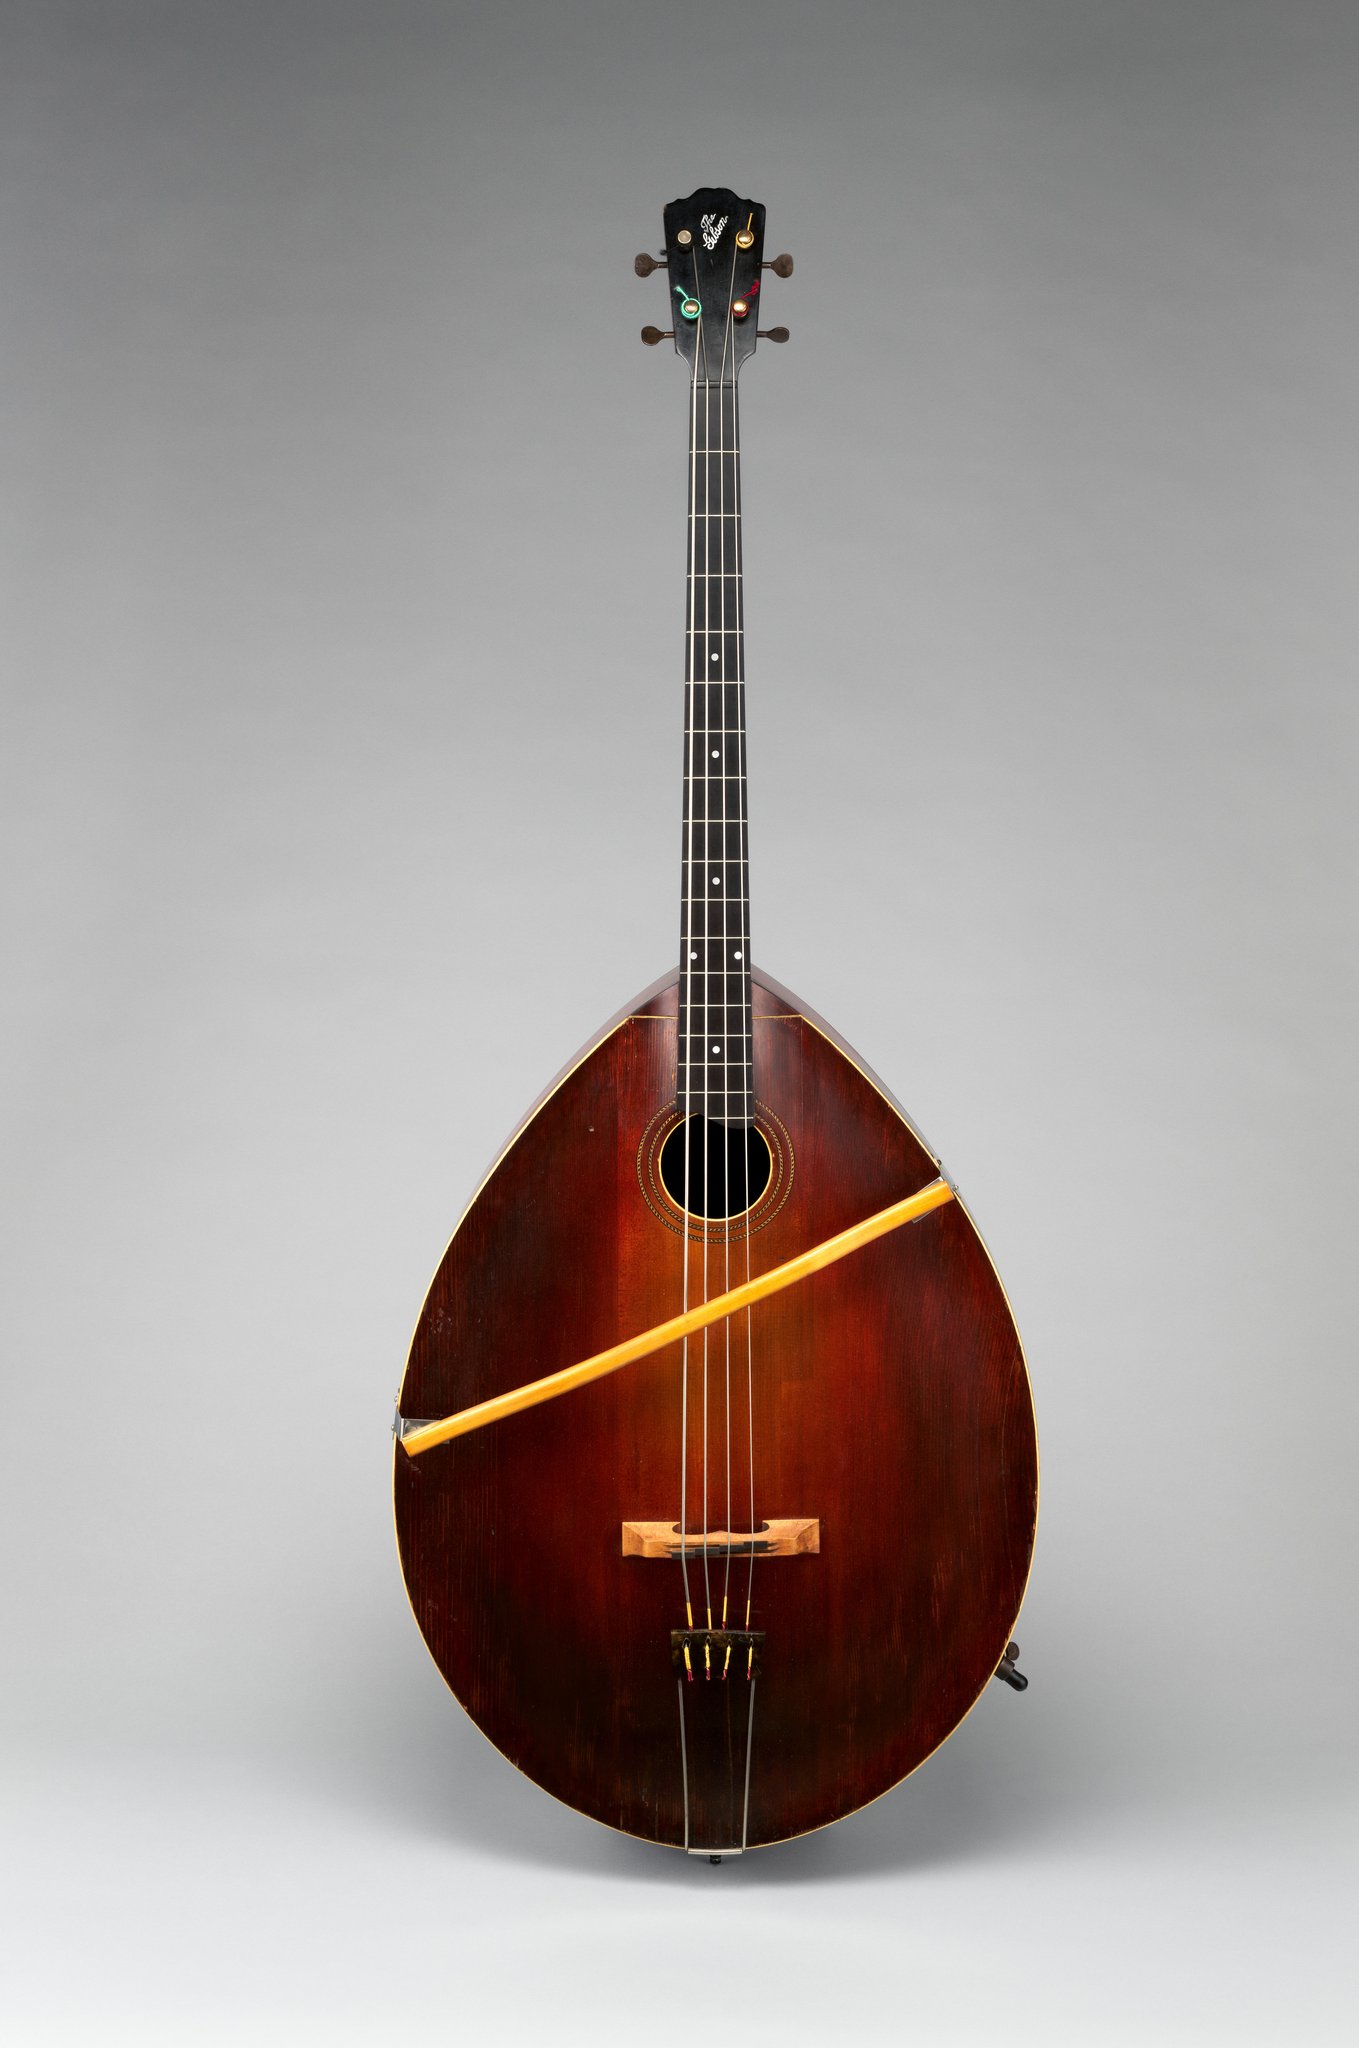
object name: mandobass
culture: american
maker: gibson mandolin-guitar manufacturing co., ltd.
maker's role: maker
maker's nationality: american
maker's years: 1902-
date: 1913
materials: brass, wood, mother of pearl, nickel, silver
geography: united states